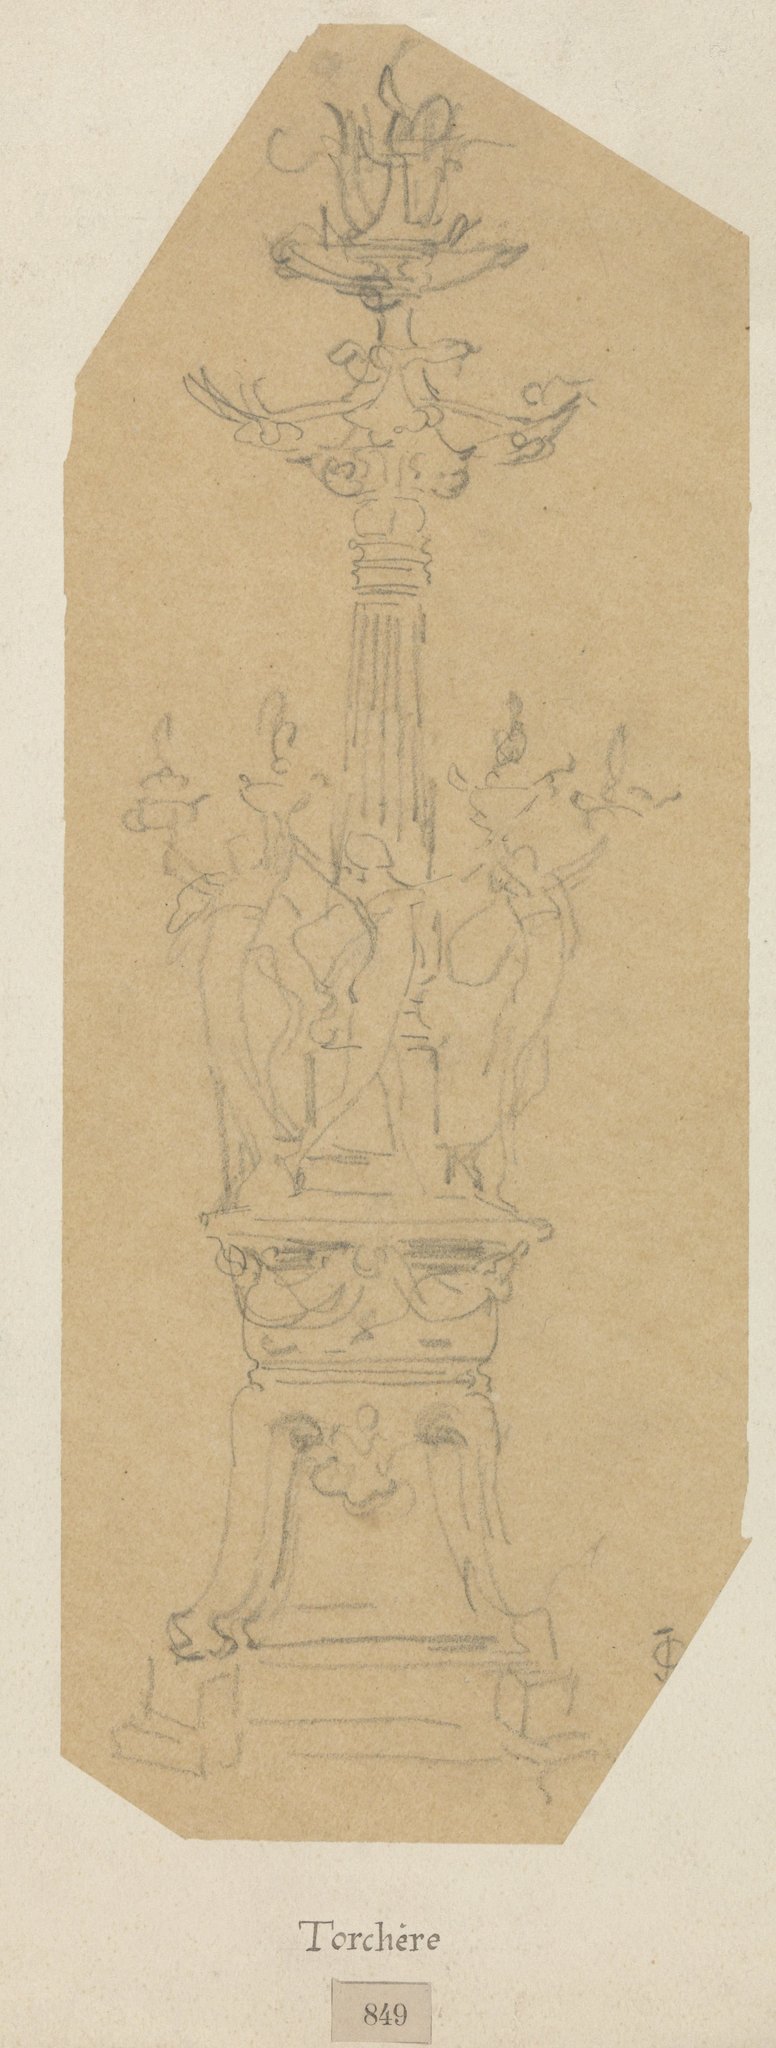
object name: design drawing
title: Grote torchère met dansende figuren die lampen vasthouden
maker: gustave joseph chéret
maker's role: sculptor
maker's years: 1838-1894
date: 1870-1894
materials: cardboard, graphite, ink, paper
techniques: pen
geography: paris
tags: chandelier, candelabrum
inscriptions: label: ‘849’, monogram: ‘JC’, inscription: ‘Torchère’, workshop stamp: ‘Joseph Chéret’